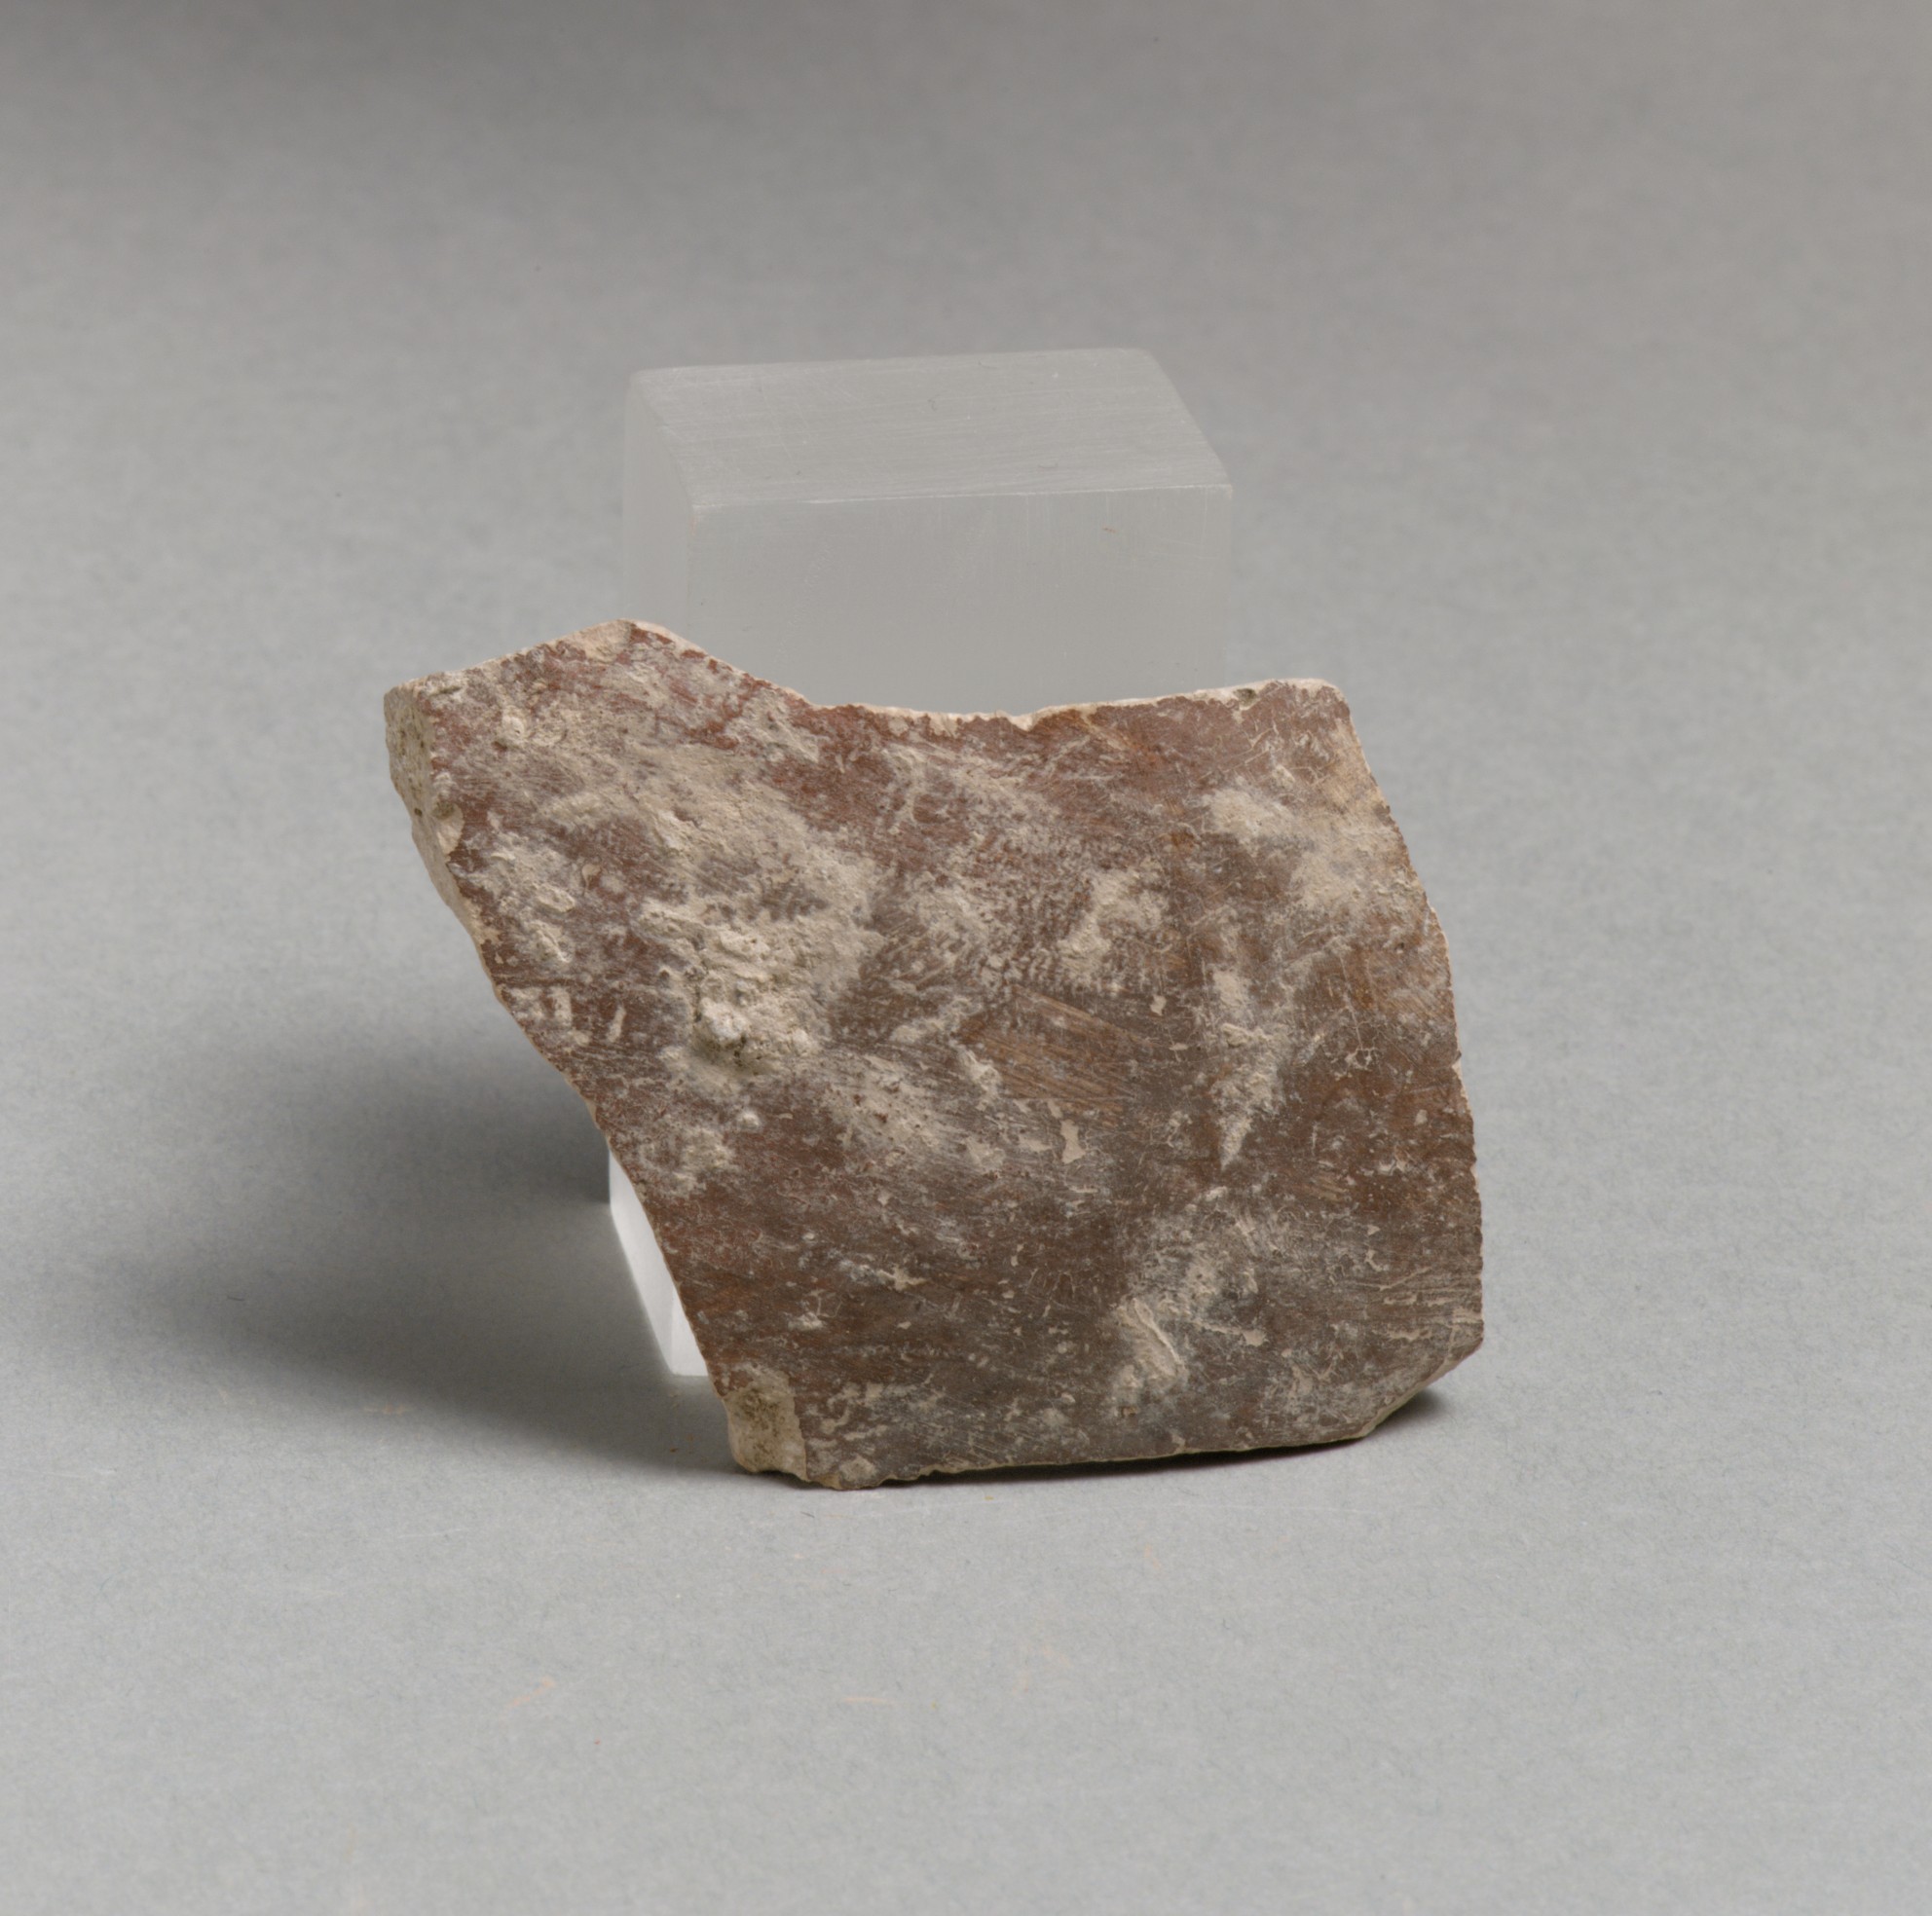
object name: vase fragment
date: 3000-2200 BCE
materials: terracotta